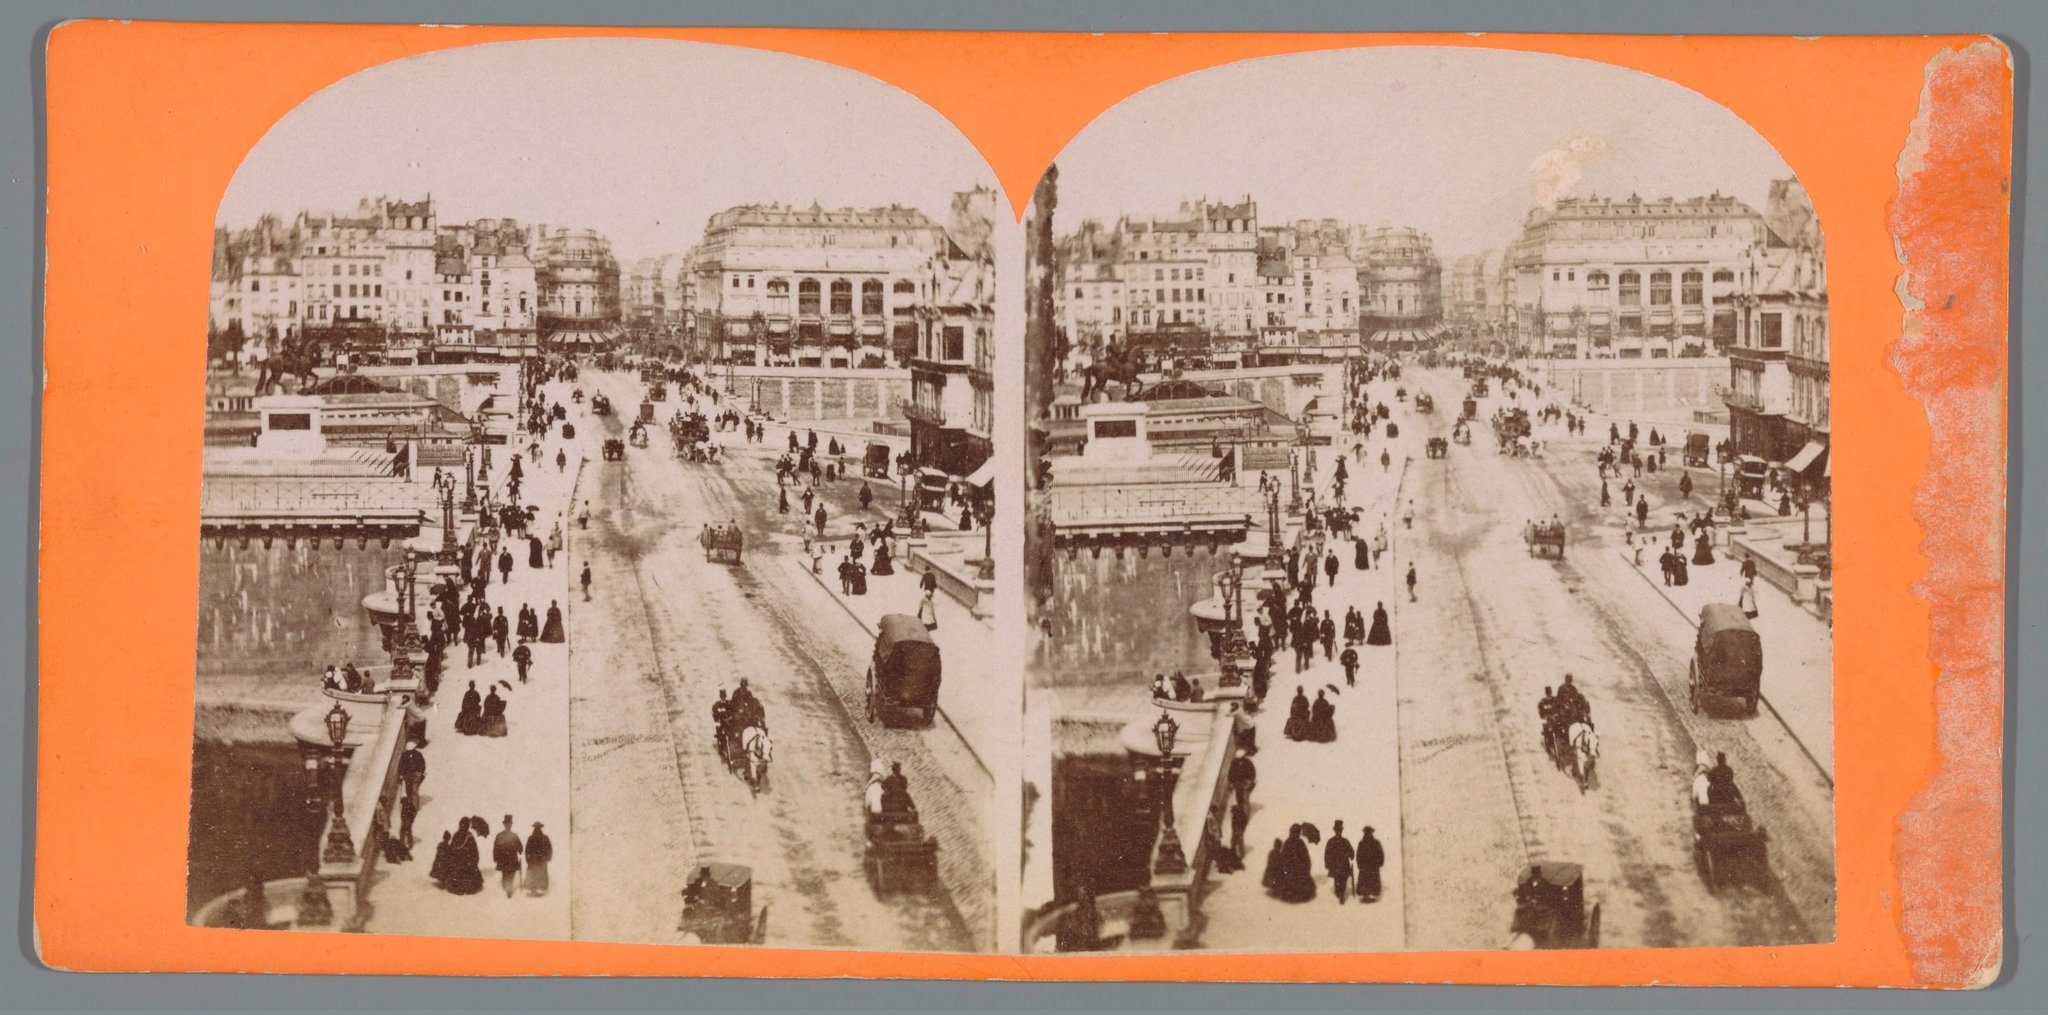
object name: stereograph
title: Gezicht op de Pont Neuf in Parijs met een ruiterstandbeeld van Hendrik IV van Frankrijk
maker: Anonymous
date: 1850-1880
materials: cardboard, photographic support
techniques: albumen print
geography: paris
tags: animal traction, animal-drawn vehicle (carriage etc.), bridge in city across river, canal, etc.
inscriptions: inscription: ‘Henri IV sur le Pont Neuf’